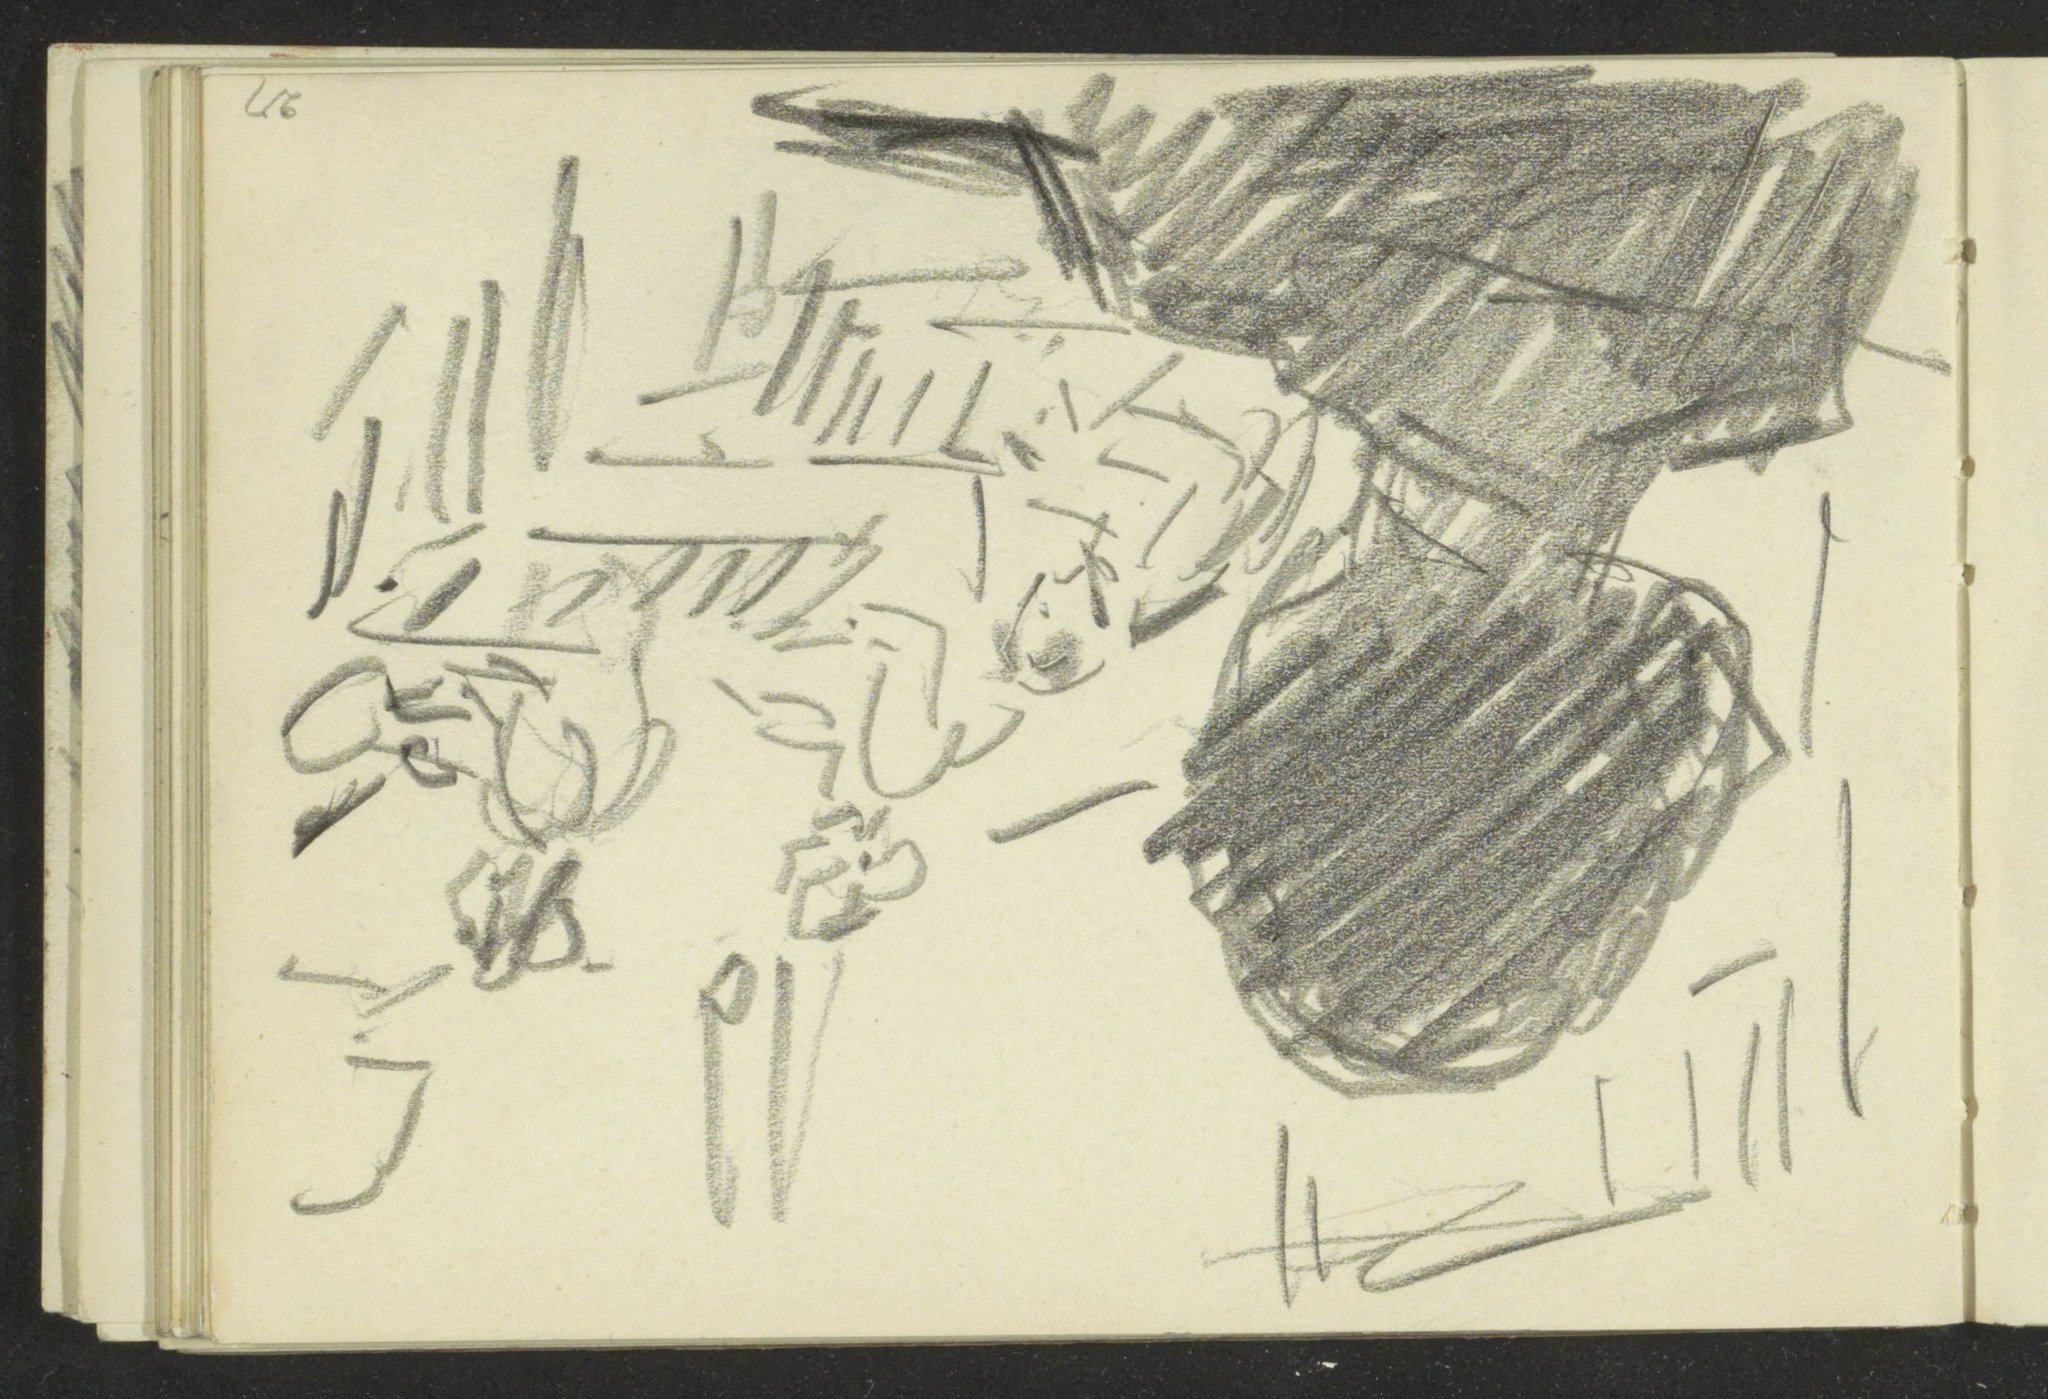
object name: sketchbook leaf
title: Xylofoonspelers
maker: isaac israels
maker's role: draughtsman, painter, print maker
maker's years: 1865-1934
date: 1875-1934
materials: paper, pencil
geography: the hague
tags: other percussion instruments, the audience ~ art performance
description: Vooraan mogelijk een toeschouwer. Blad 24 verso uit schetsboek LXV met 27 bladen.